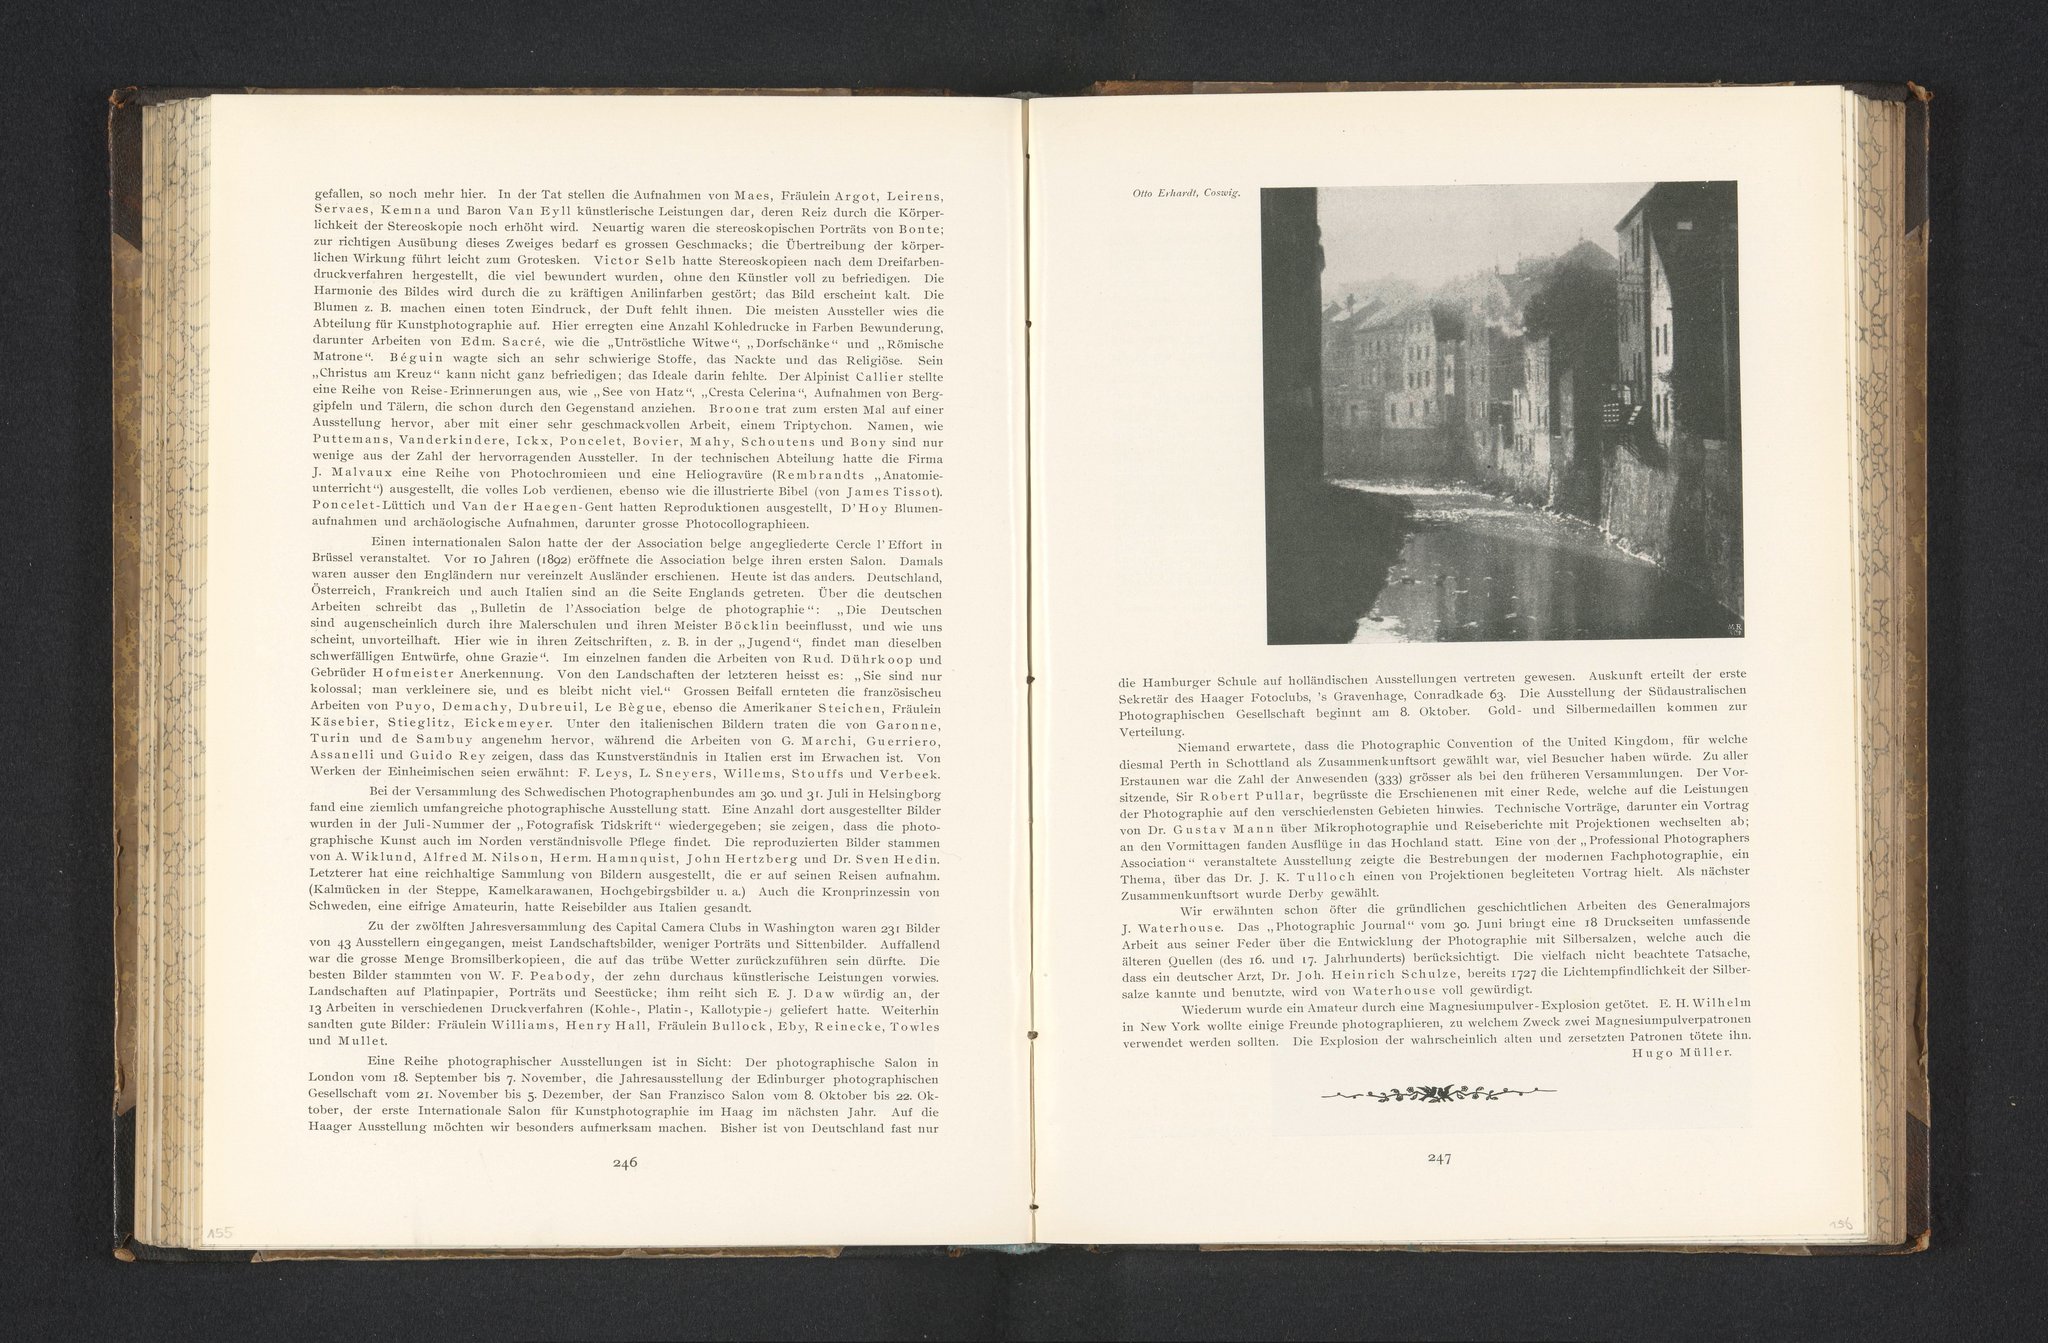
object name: photomechanical print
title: Gezicht op een rij huizen aan het water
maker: otto erhardt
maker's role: fotograaf, leraar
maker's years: 1869-1942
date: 1898-1903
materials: paper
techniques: autotype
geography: berlin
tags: canals, waters (in city), the usual house or row of houses